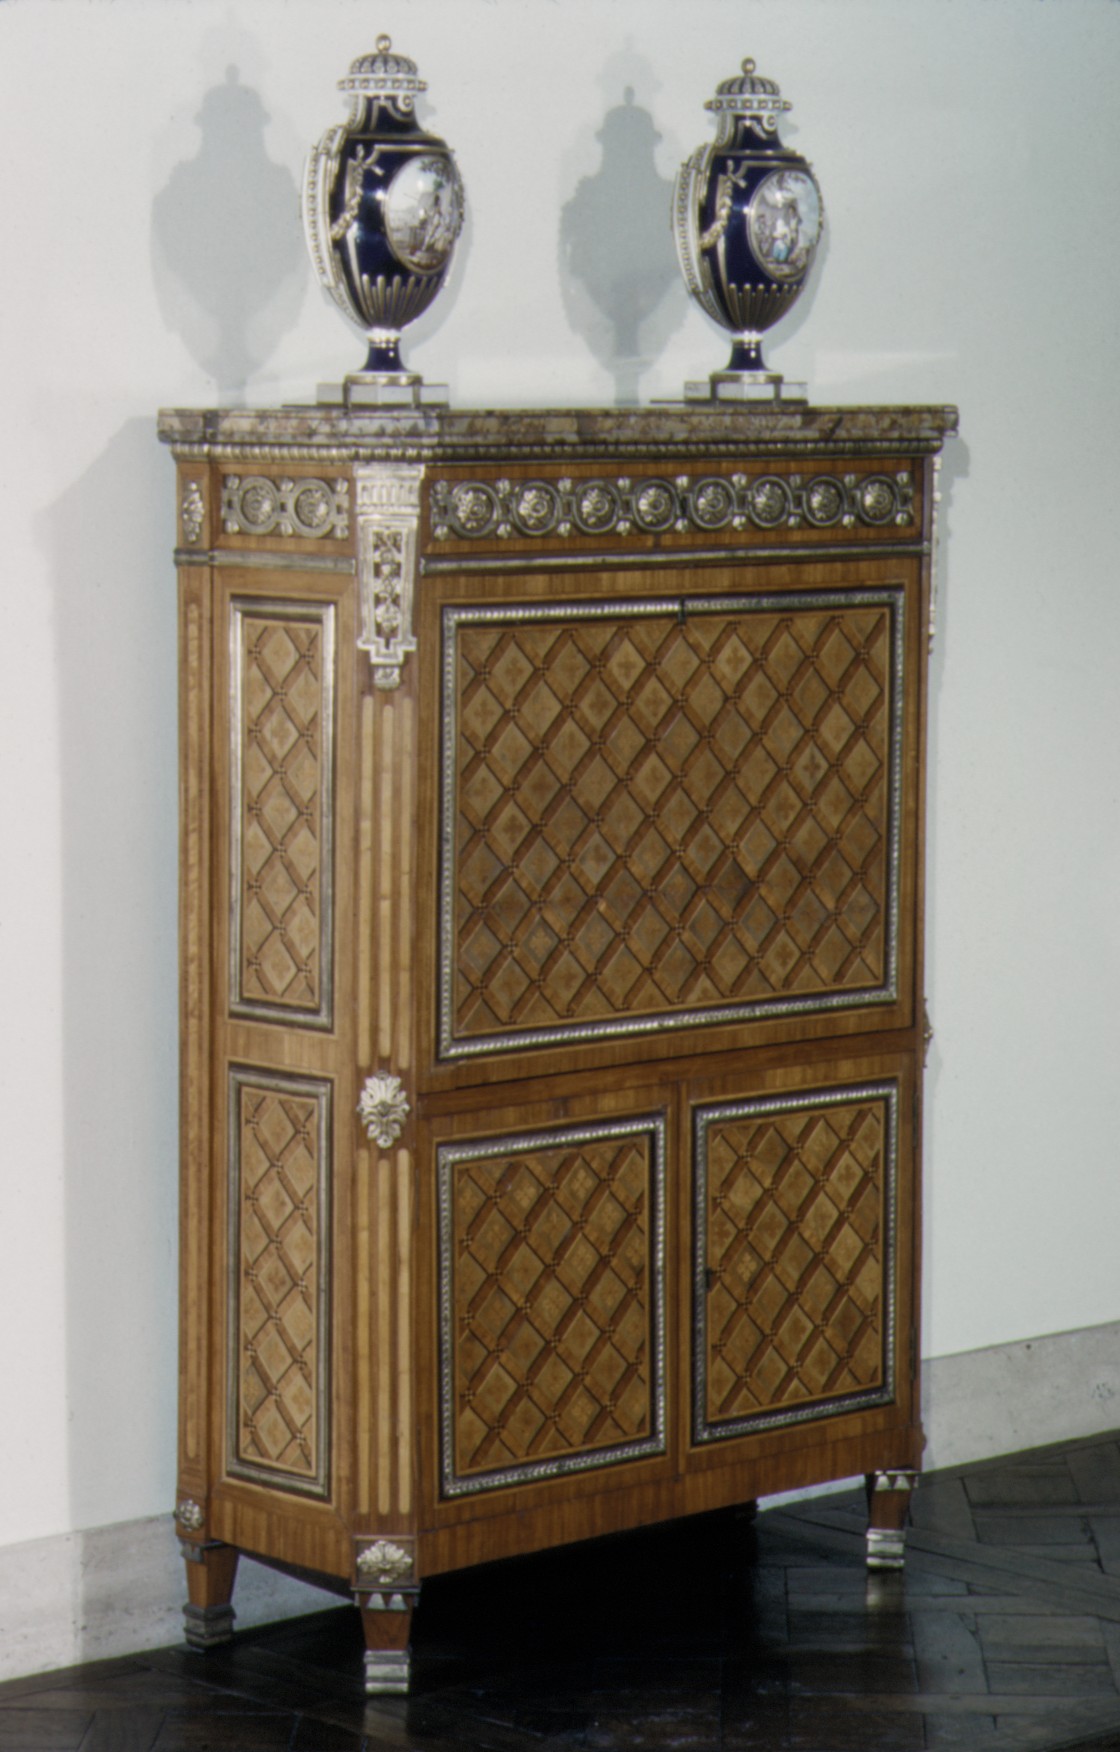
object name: secretary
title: Upright secretary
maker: guillaume kemp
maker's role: maker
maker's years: 1757-1786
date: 1775-1780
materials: gilt bronze, marble, wood, textile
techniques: stain